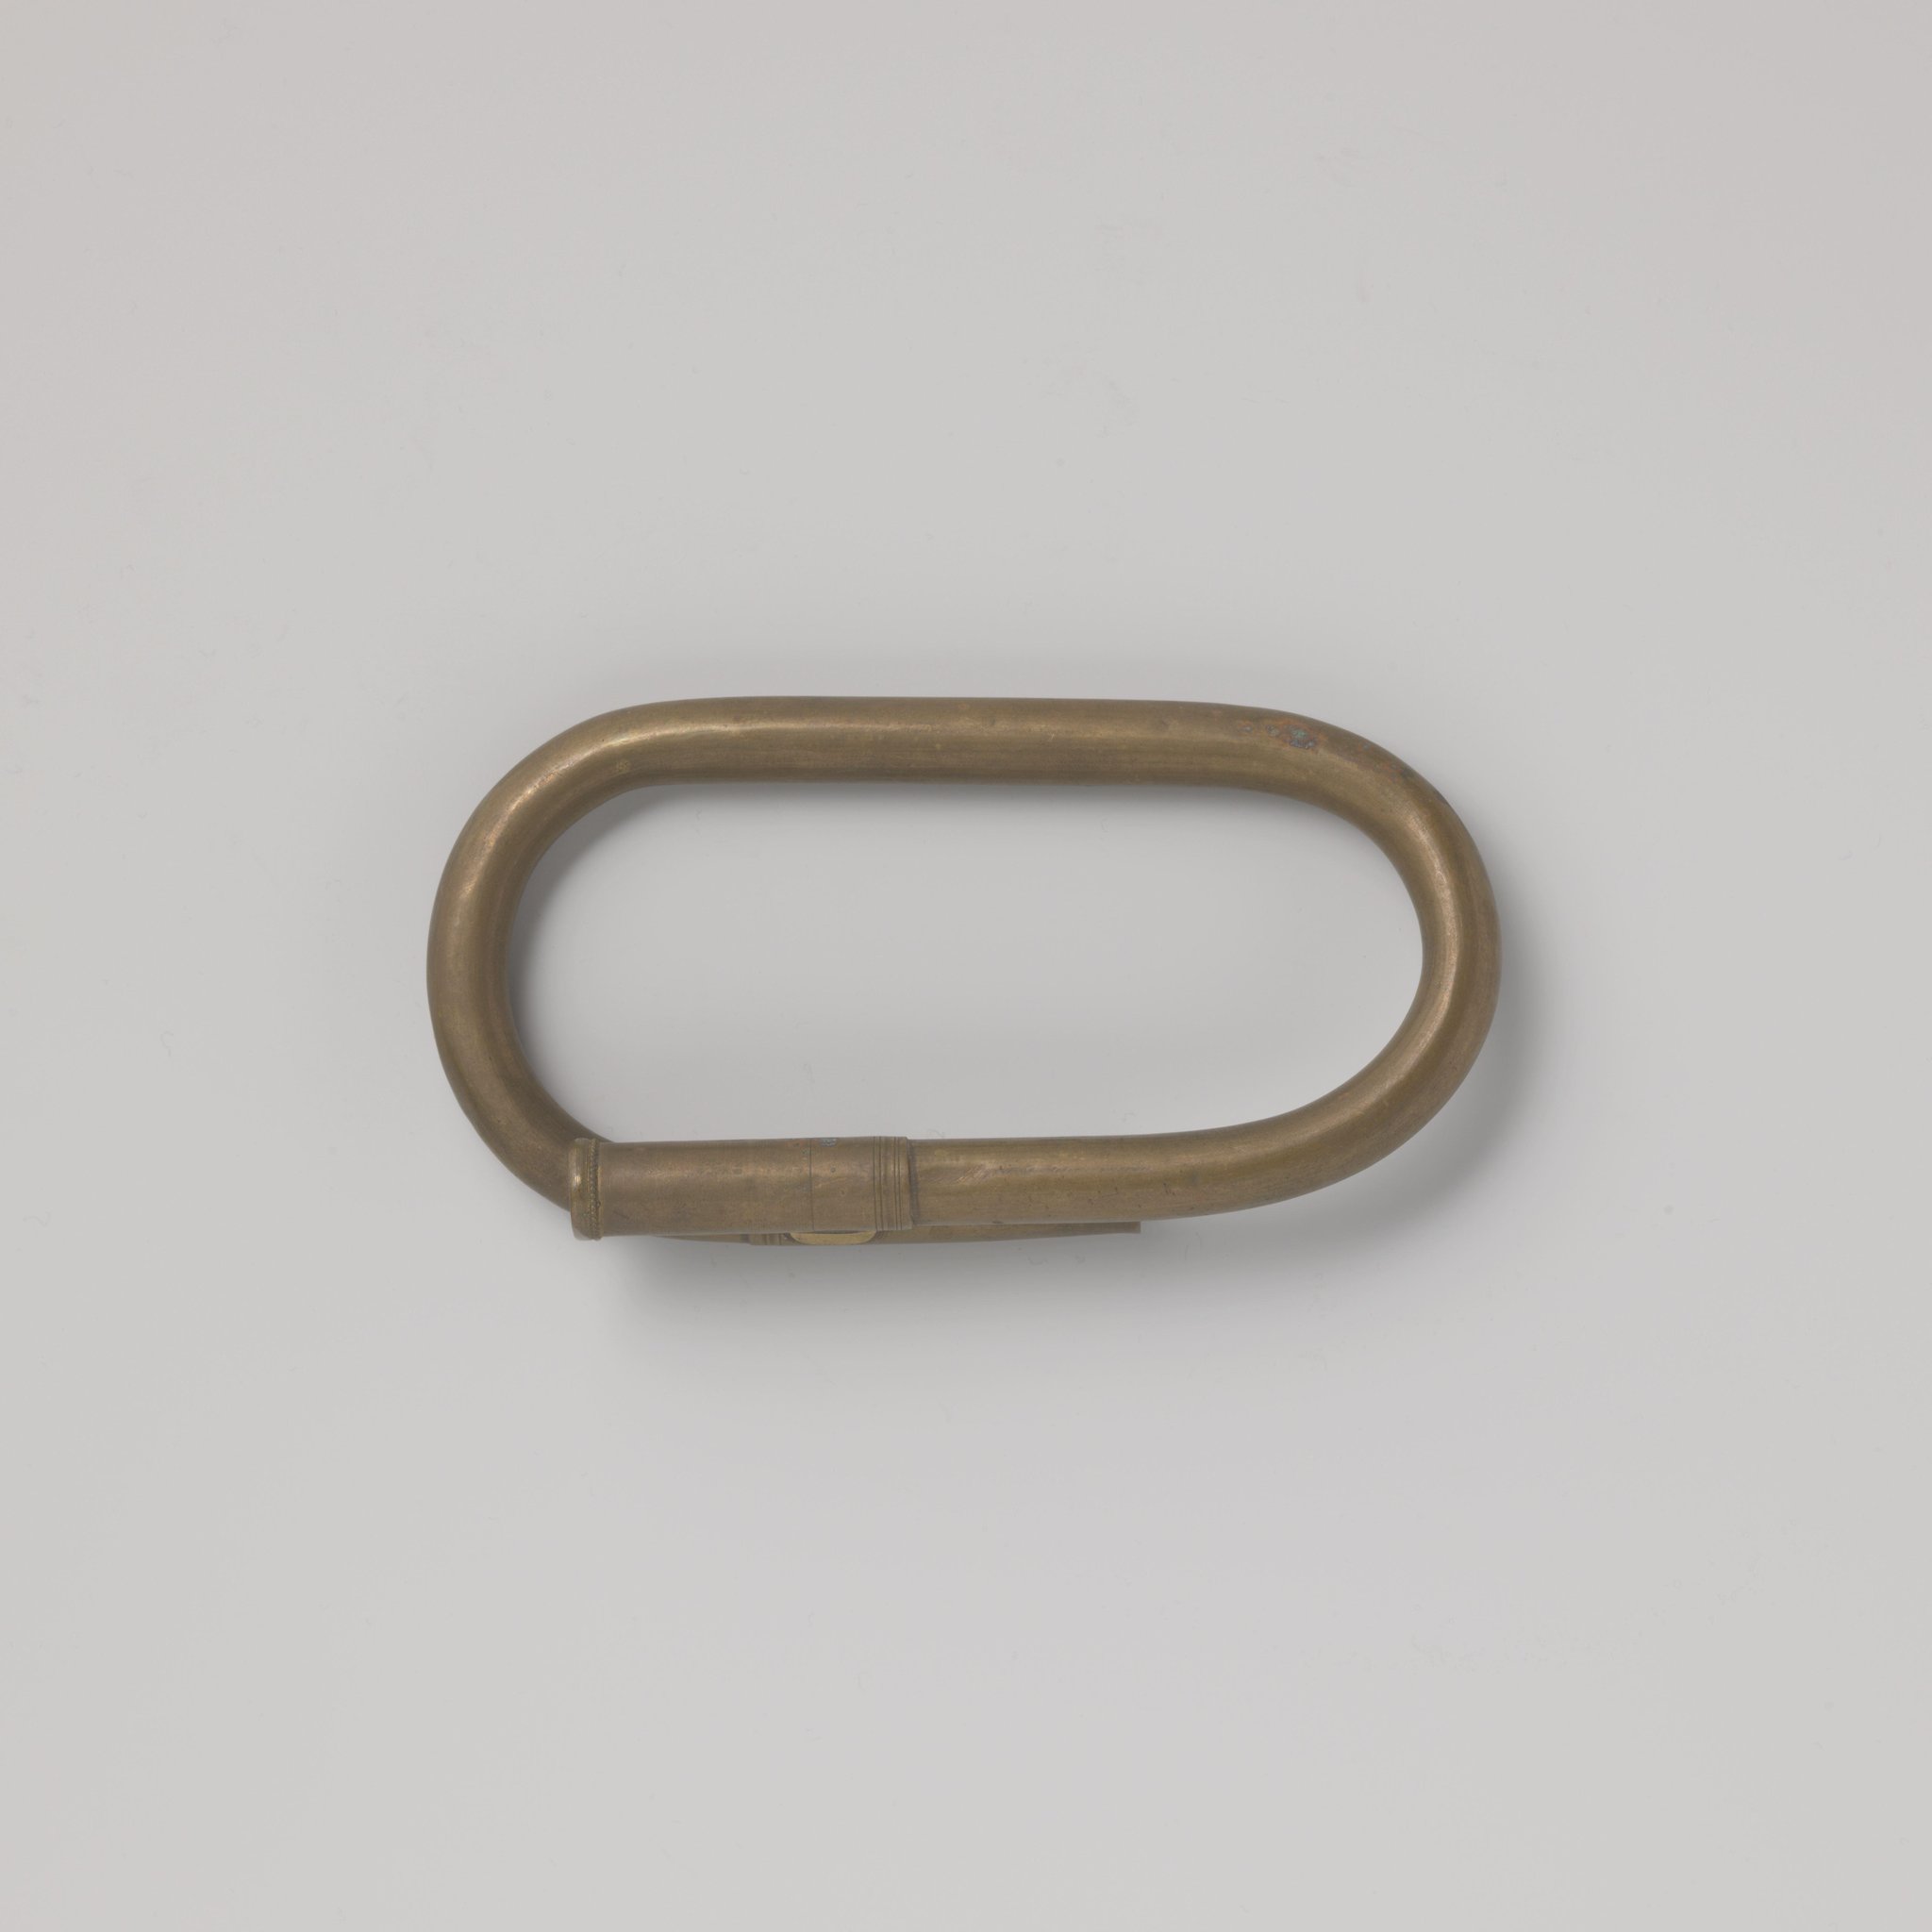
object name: horn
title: Invention horn crook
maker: carl gottlob schüster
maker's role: instrument maker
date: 1850-1950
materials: copper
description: Beugel van inventionshoorn. Niet gemerkt